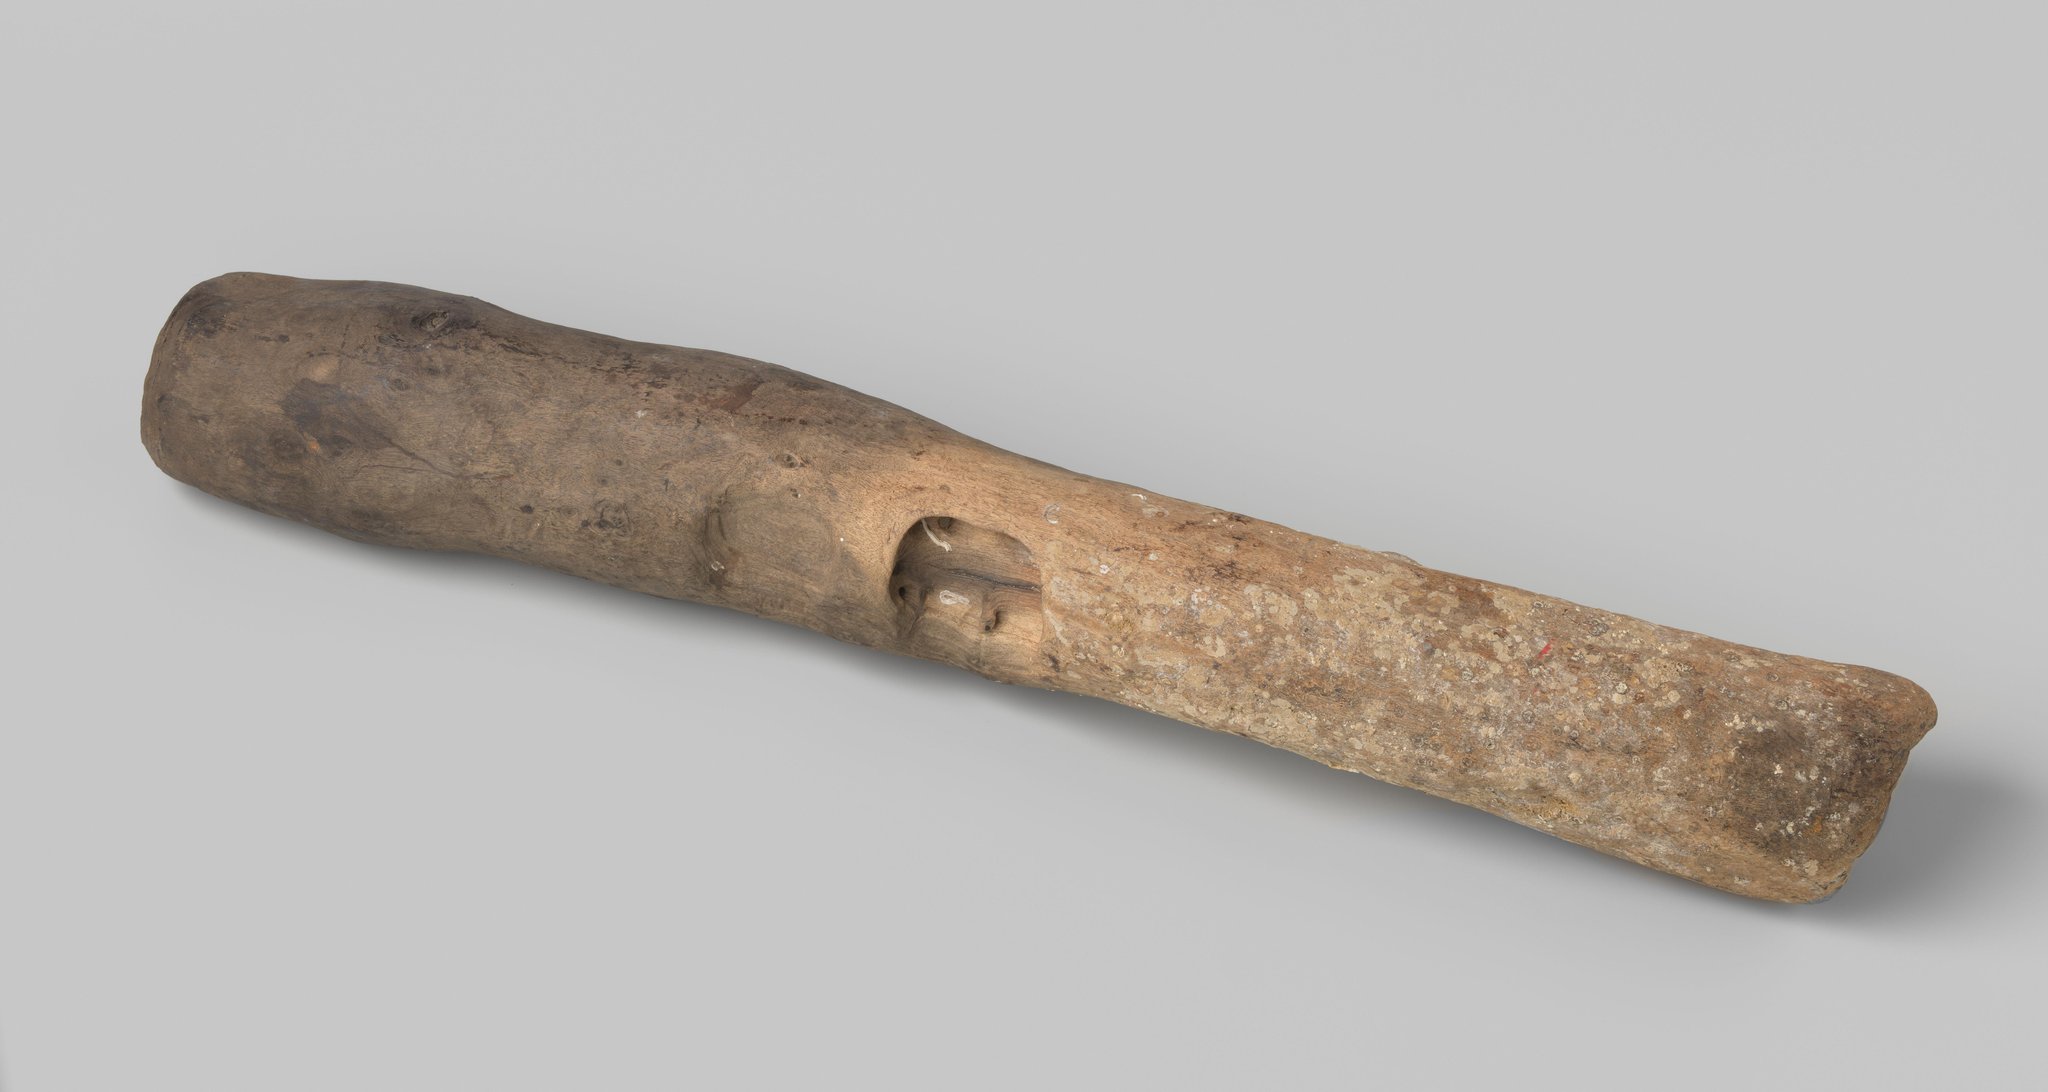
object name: verfhout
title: Paint wood (sappan) from the wreck of the Dutch East Indiaman Boot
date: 1738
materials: wood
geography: taiwan strait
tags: boot (schip), verenigde oostindische compagnie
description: Het stuk sappanhout is afkomstig uit het wrak van het VOC-retourschip (hekboot) 'Boot', dat op 8 november 1738 op de zesde reis bij Prawle Point (Zuid-Devon/Groot Brittannië) is vergaan. Het schip was op 2 april 1738 uit Batavia vertrokken, arriveerde op 31 juli op Kaap de Goede Hoop (Zuid-Afrika) en vertrok daarvandaan op 12 augustus met de bestemming Amsterdam. De hekboot 'Boot' was in 1733 voor de VOC-Kamer Rotterdam te Rotterdam gebouwd en mat 650 ton. Het maakte reizen voor de VOC-kamers Rotterdam, Zeeland en Amsterdam. De Belgische berger Robert Sténuit heeft objecten uit dit wrak geborgen en dit stuk aan het Rijksmuseum geschonken.